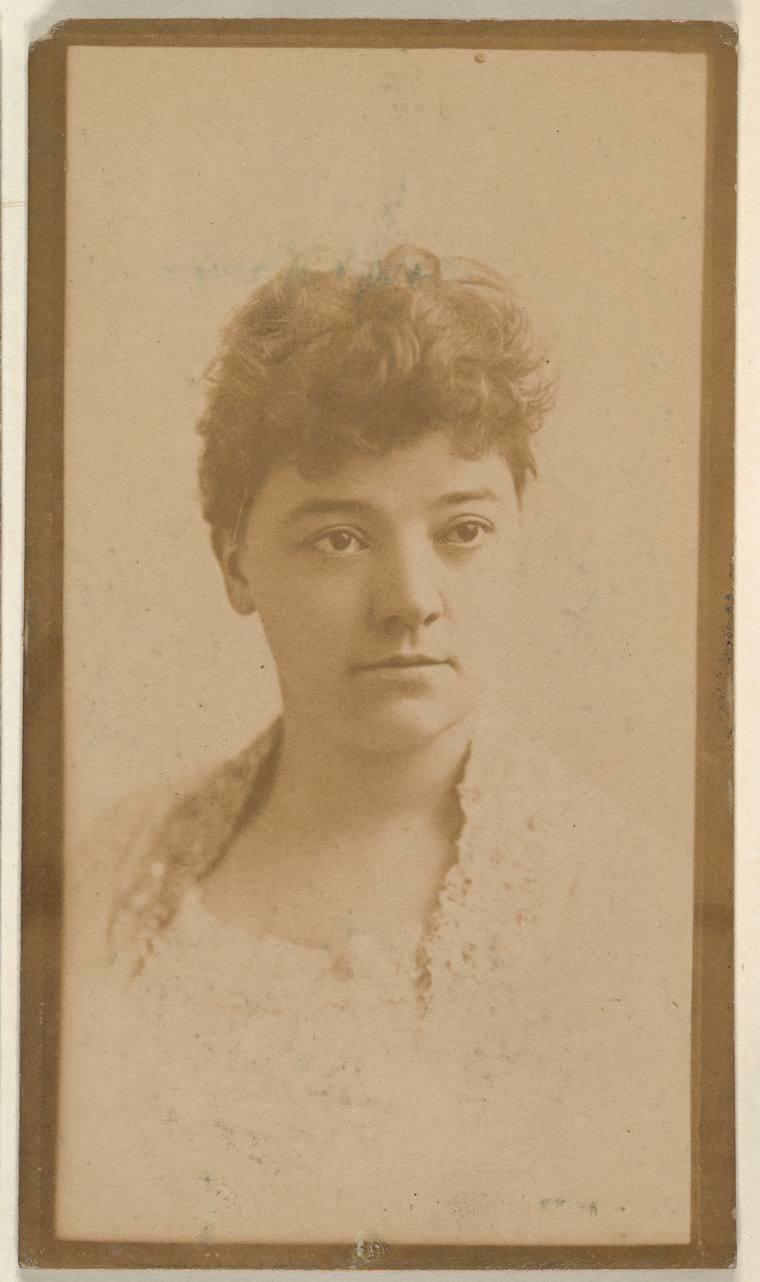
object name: photograph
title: Portrait of actress, from the Actresses series (N668)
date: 1888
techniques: albumen silver print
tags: portraits,women,actresses